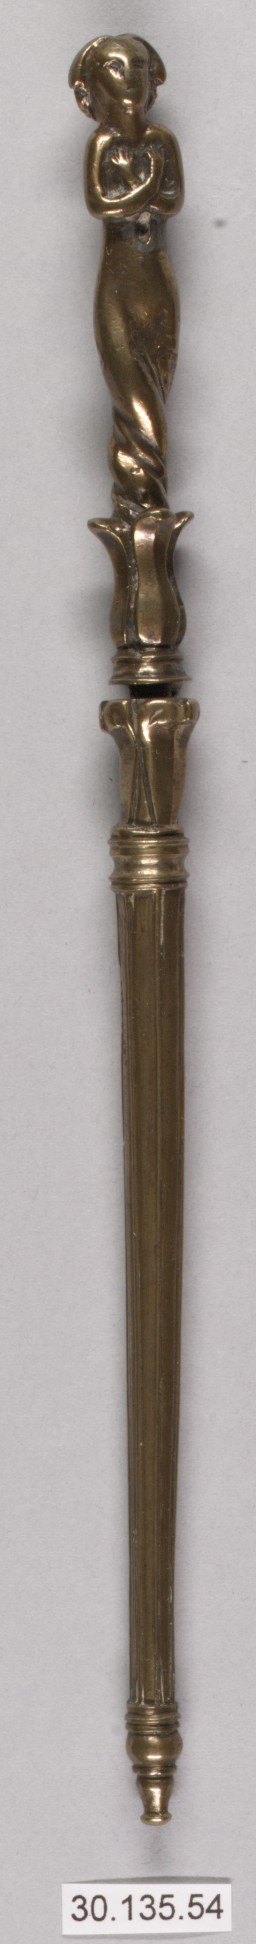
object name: needle case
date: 1601-1700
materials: bronze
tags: women